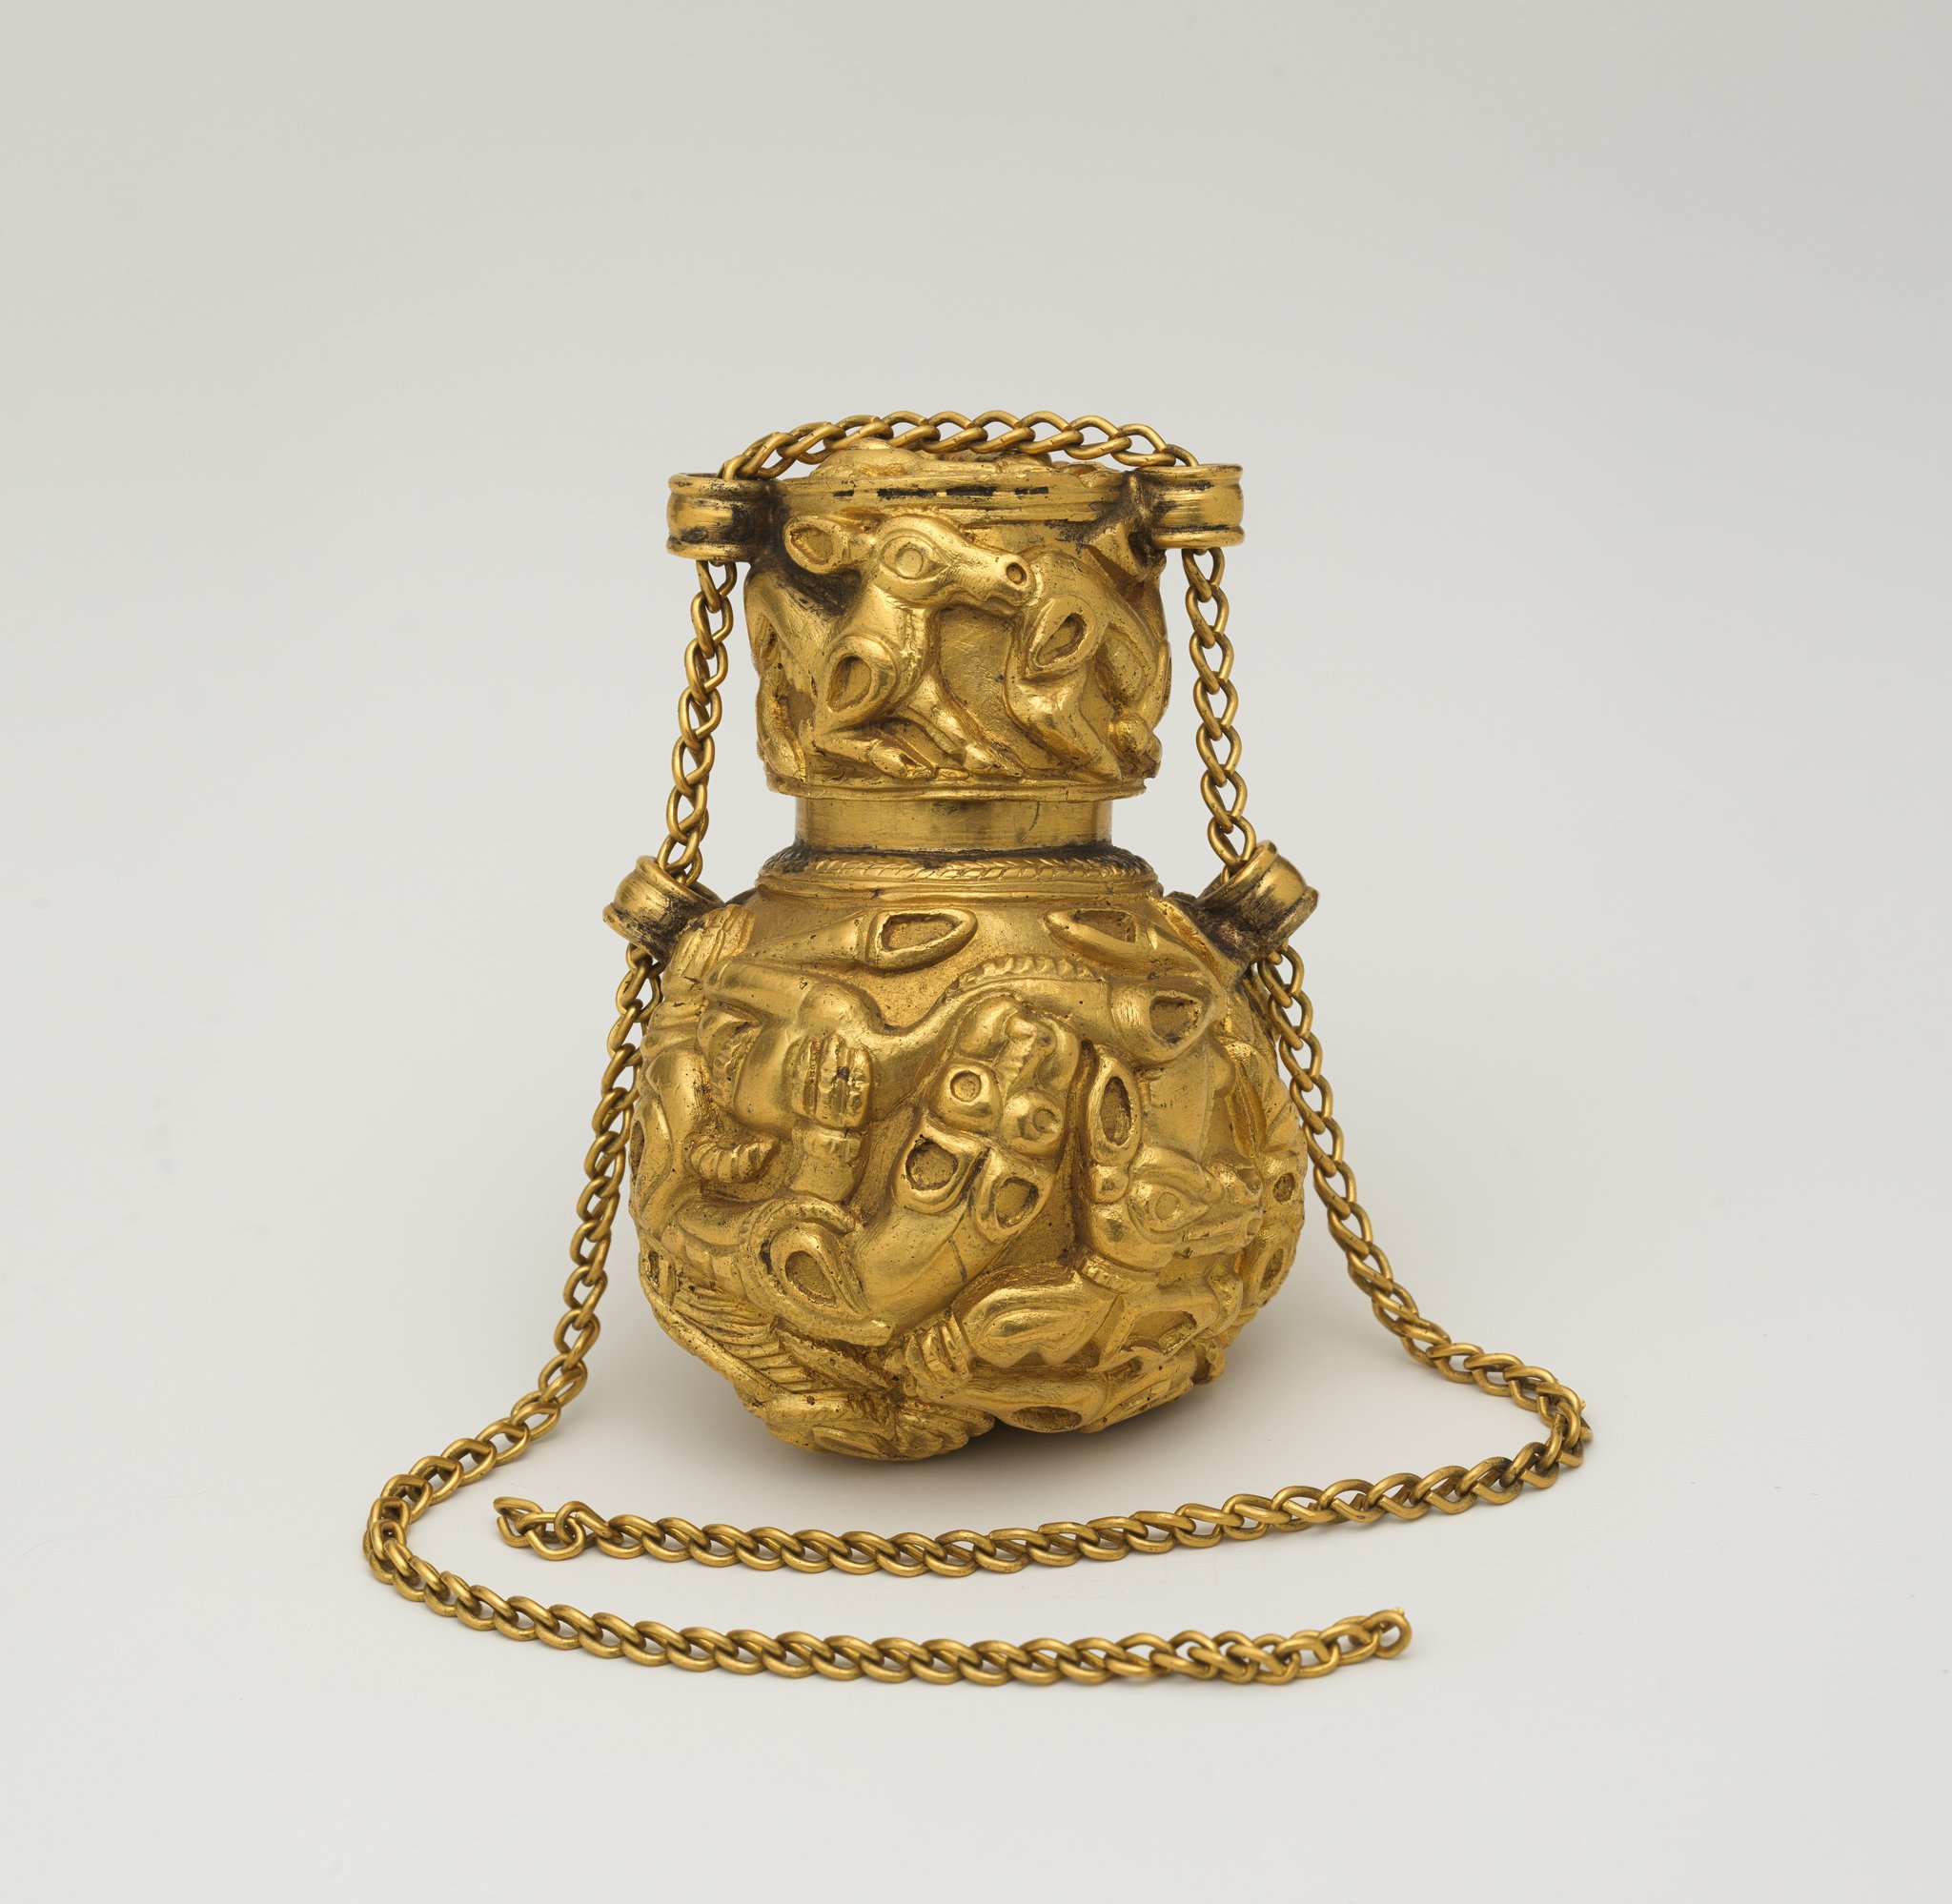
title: Reproduction of a Sarmatian bottle and lid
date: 1801-1900